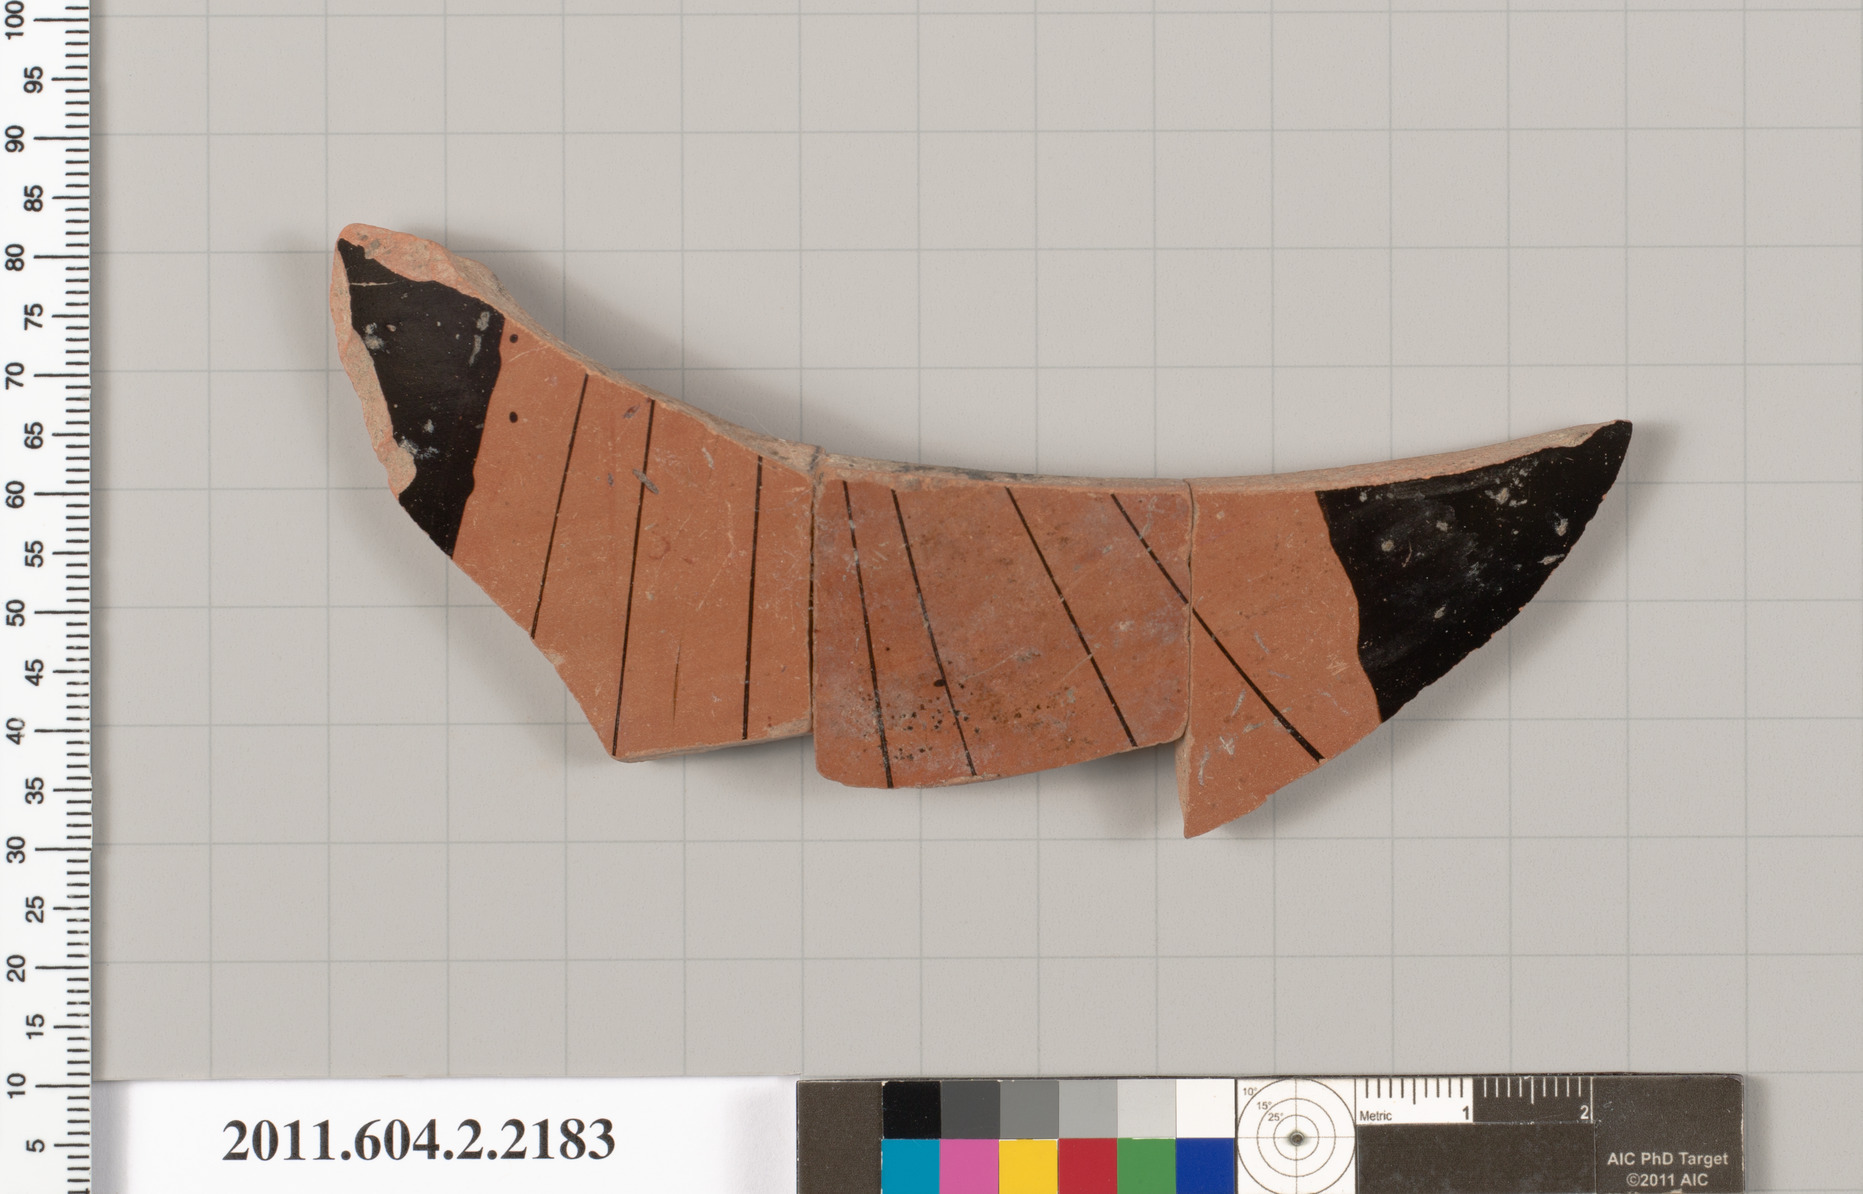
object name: pot fragment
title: Terracotta fragment of a pot; unglazed on the inside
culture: greek, attic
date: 460-450 BCE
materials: terracotta